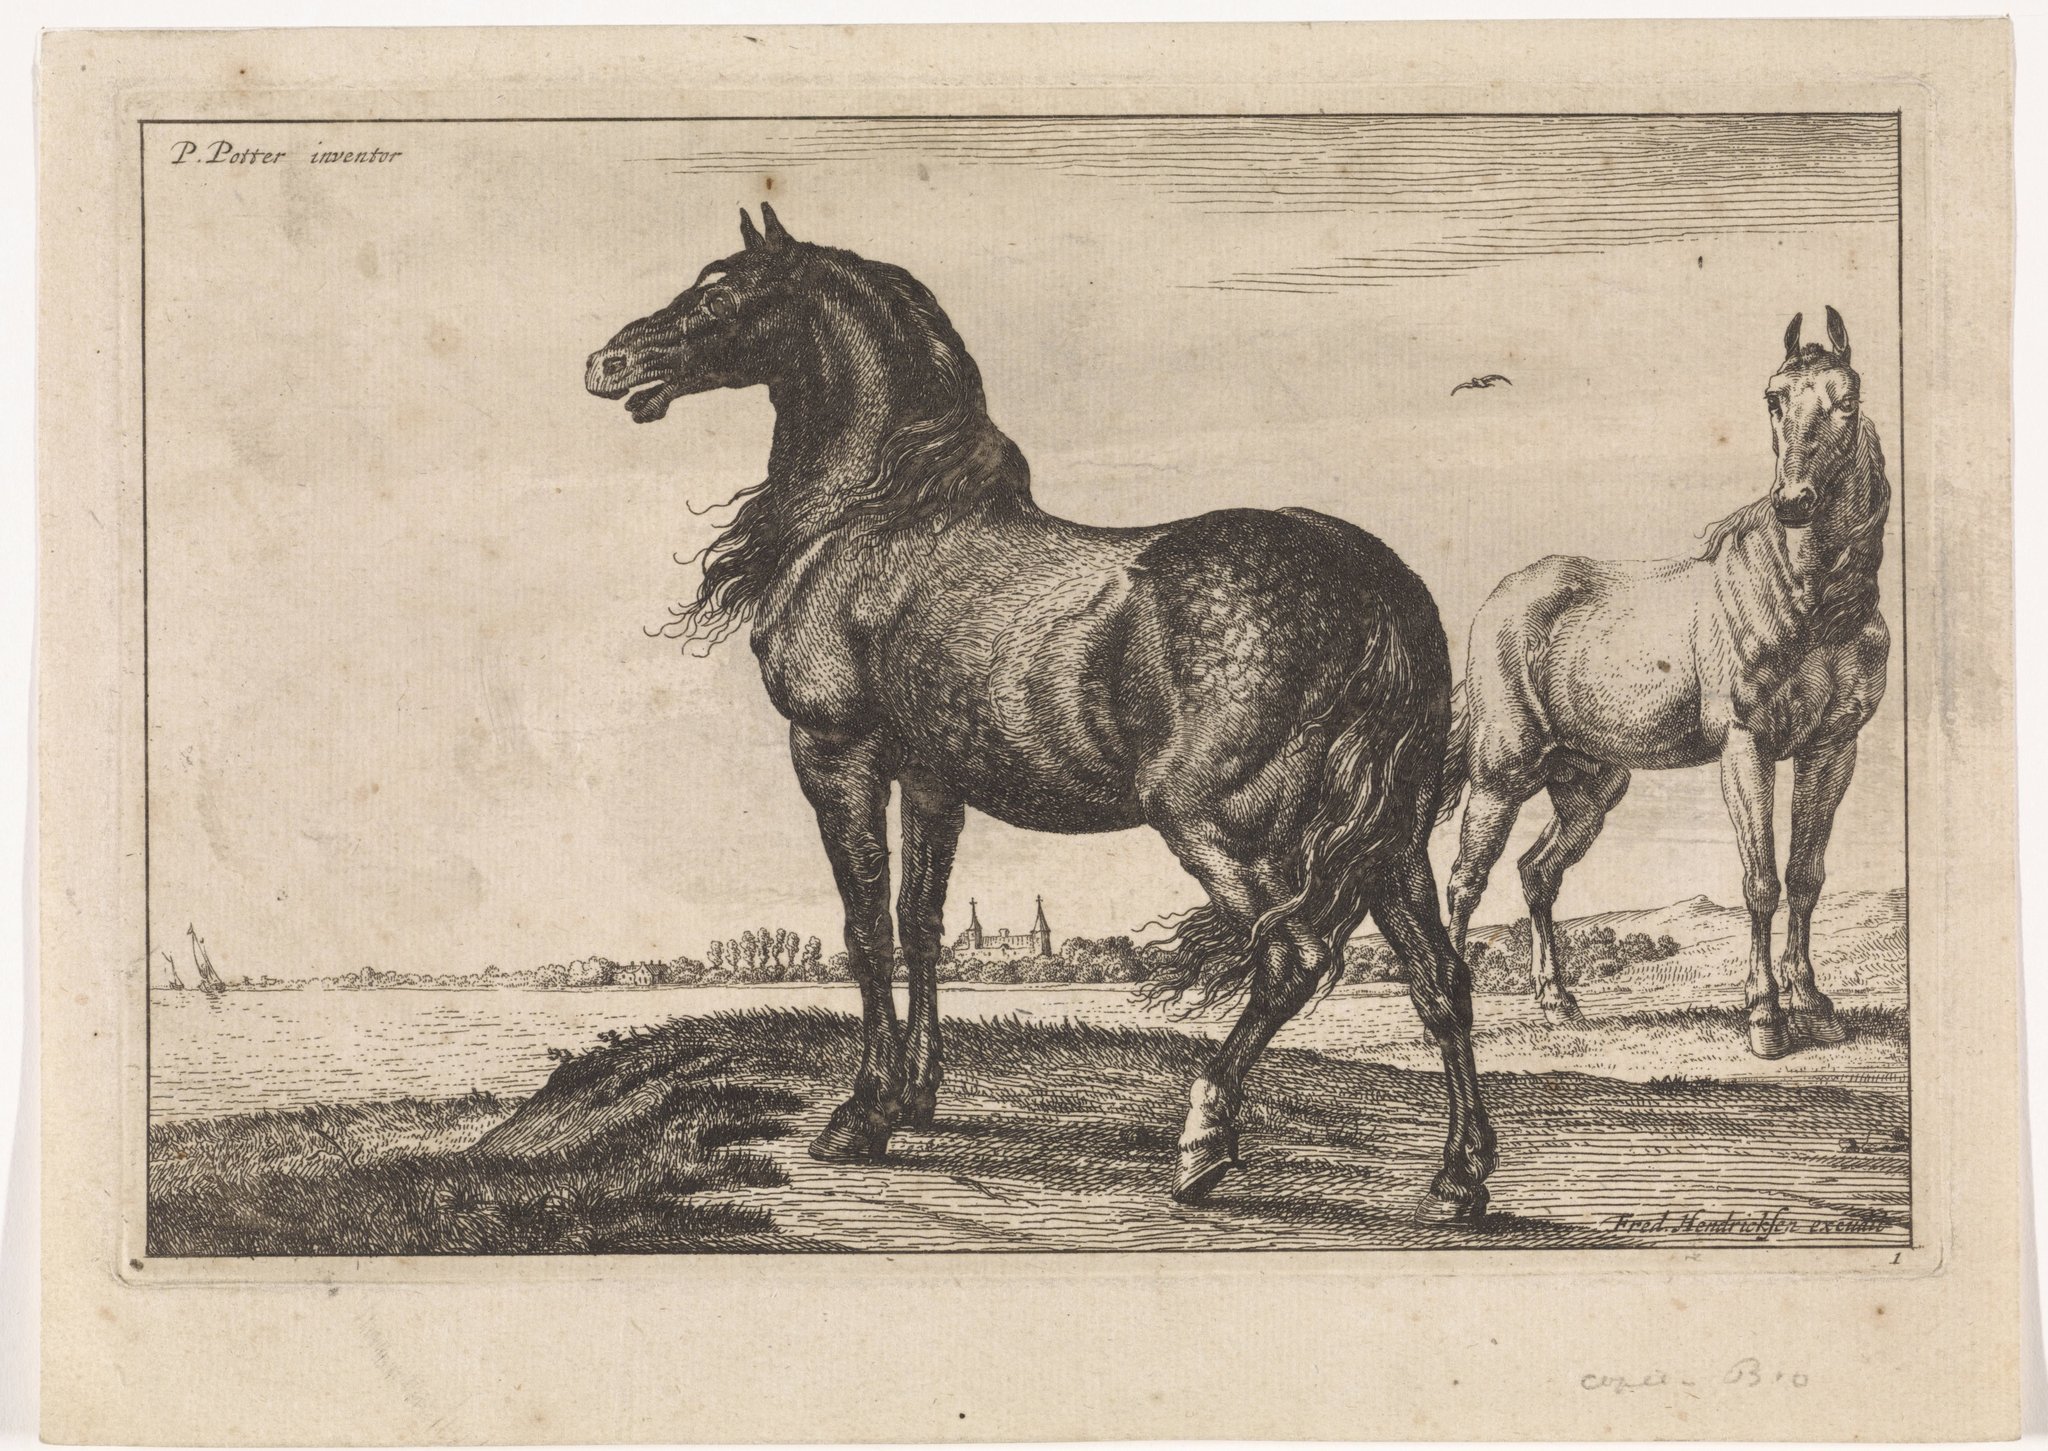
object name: print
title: Paarden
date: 1652-1702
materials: paper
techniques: etching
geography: netherlands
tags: animals (+ audible means of communication of animal(s): roaring, crying, singing, barking, mewing, neighing, chirping, etc.), horse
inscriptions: collector's mark: Lugt 2228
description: Een zwart en een wit paard op de oever van een groot water. In de verte een stad. Rechtsonder genummerd: 1.